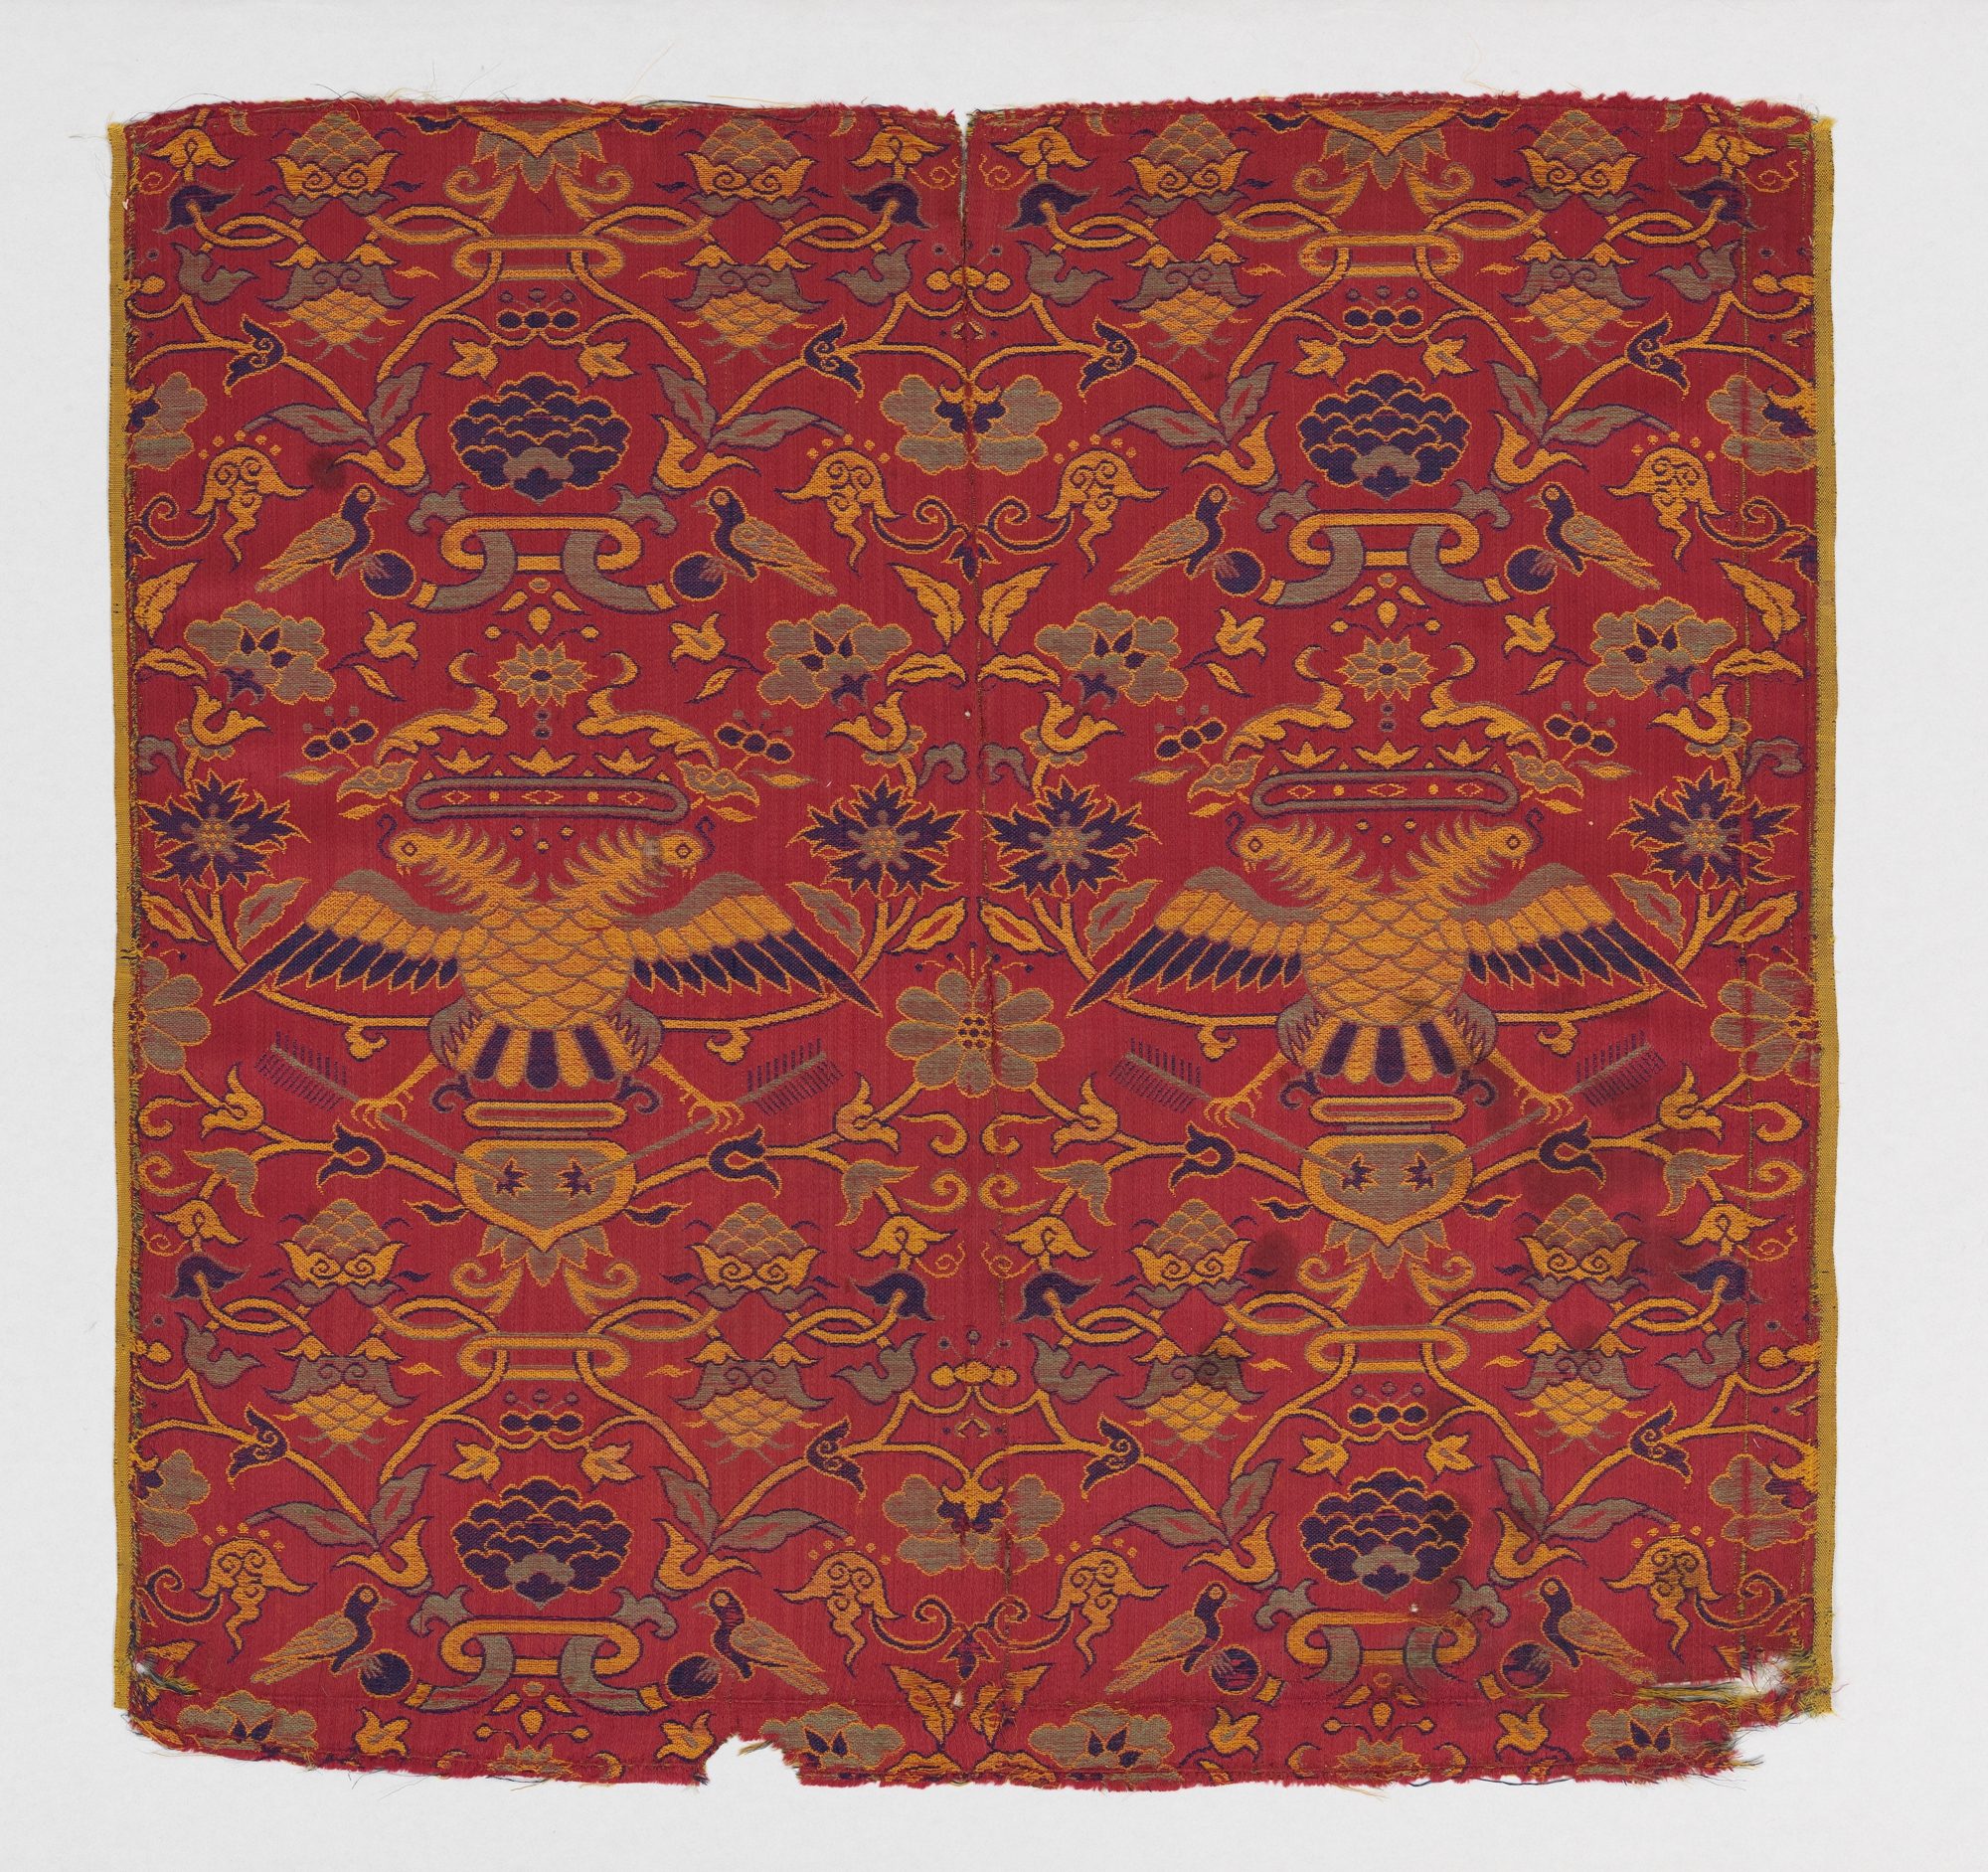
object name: piece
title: Textile with crowned double headed eagles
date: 1551-1600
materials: silk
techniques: lampas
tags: birds,eagles,flowers,leaves,coat of arms